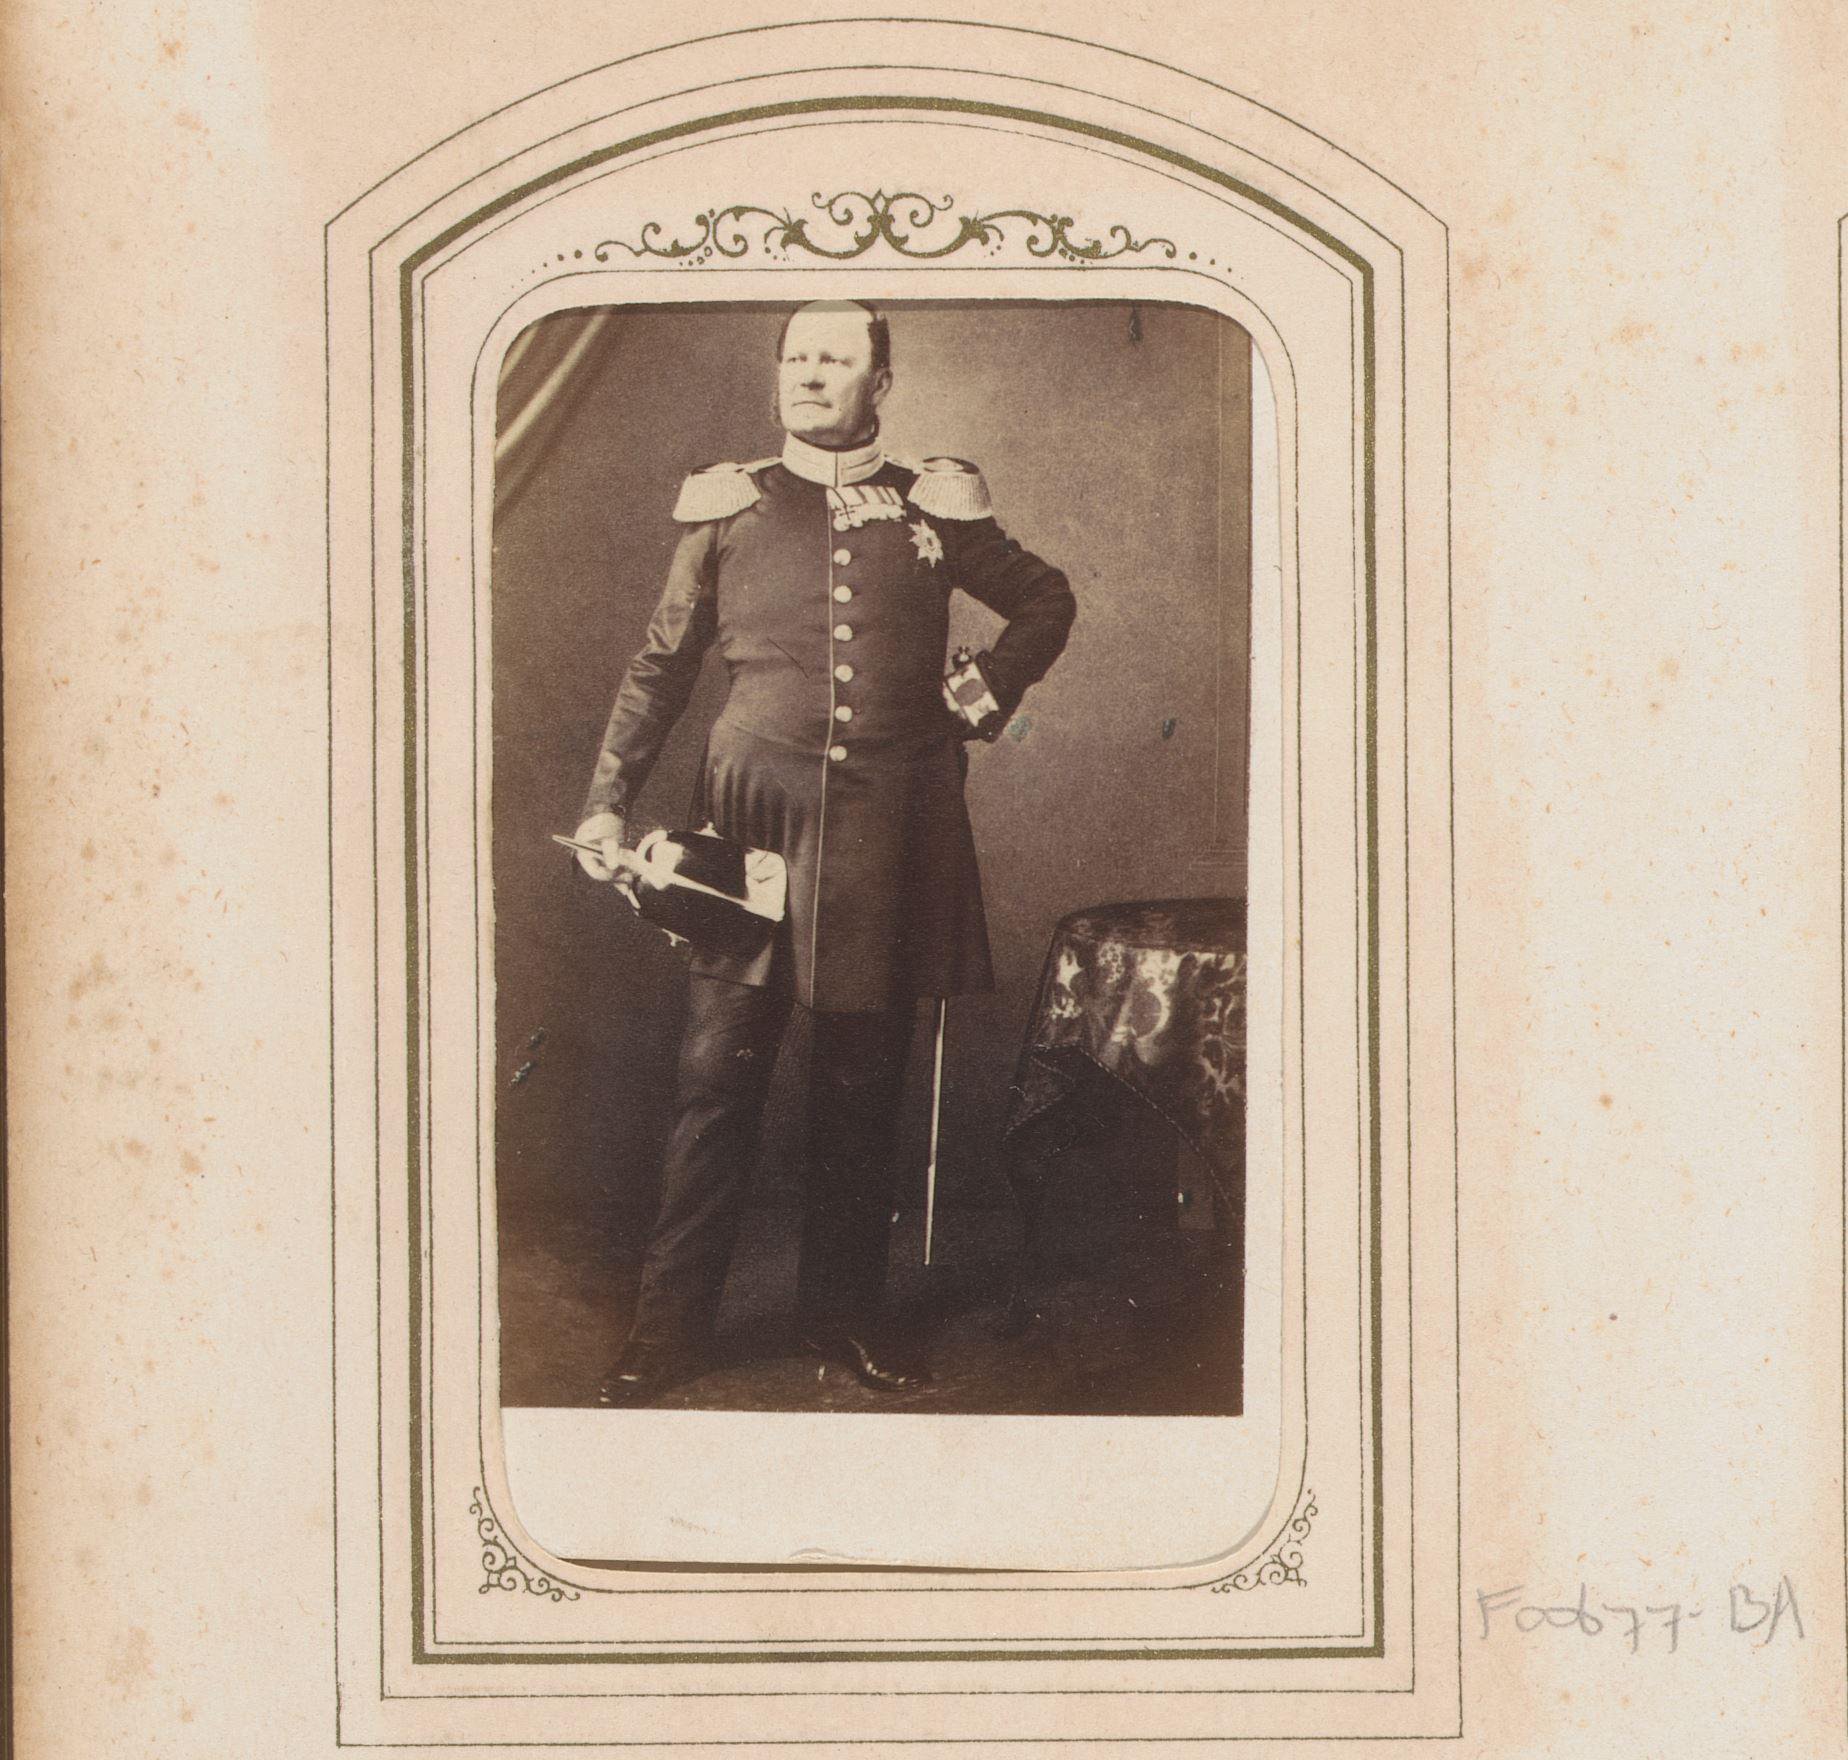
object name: album leaf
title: Portret van Frederik Willem IV, koning van Pruisen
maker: max pflaum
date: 1845-1861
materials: cardboard, photographic support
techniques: albumen print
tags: berlin, frederik willem iv (koning van pruisen), historical persons, king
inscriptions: inscription: ‘Berlin, Leipzigerstrasse 44’